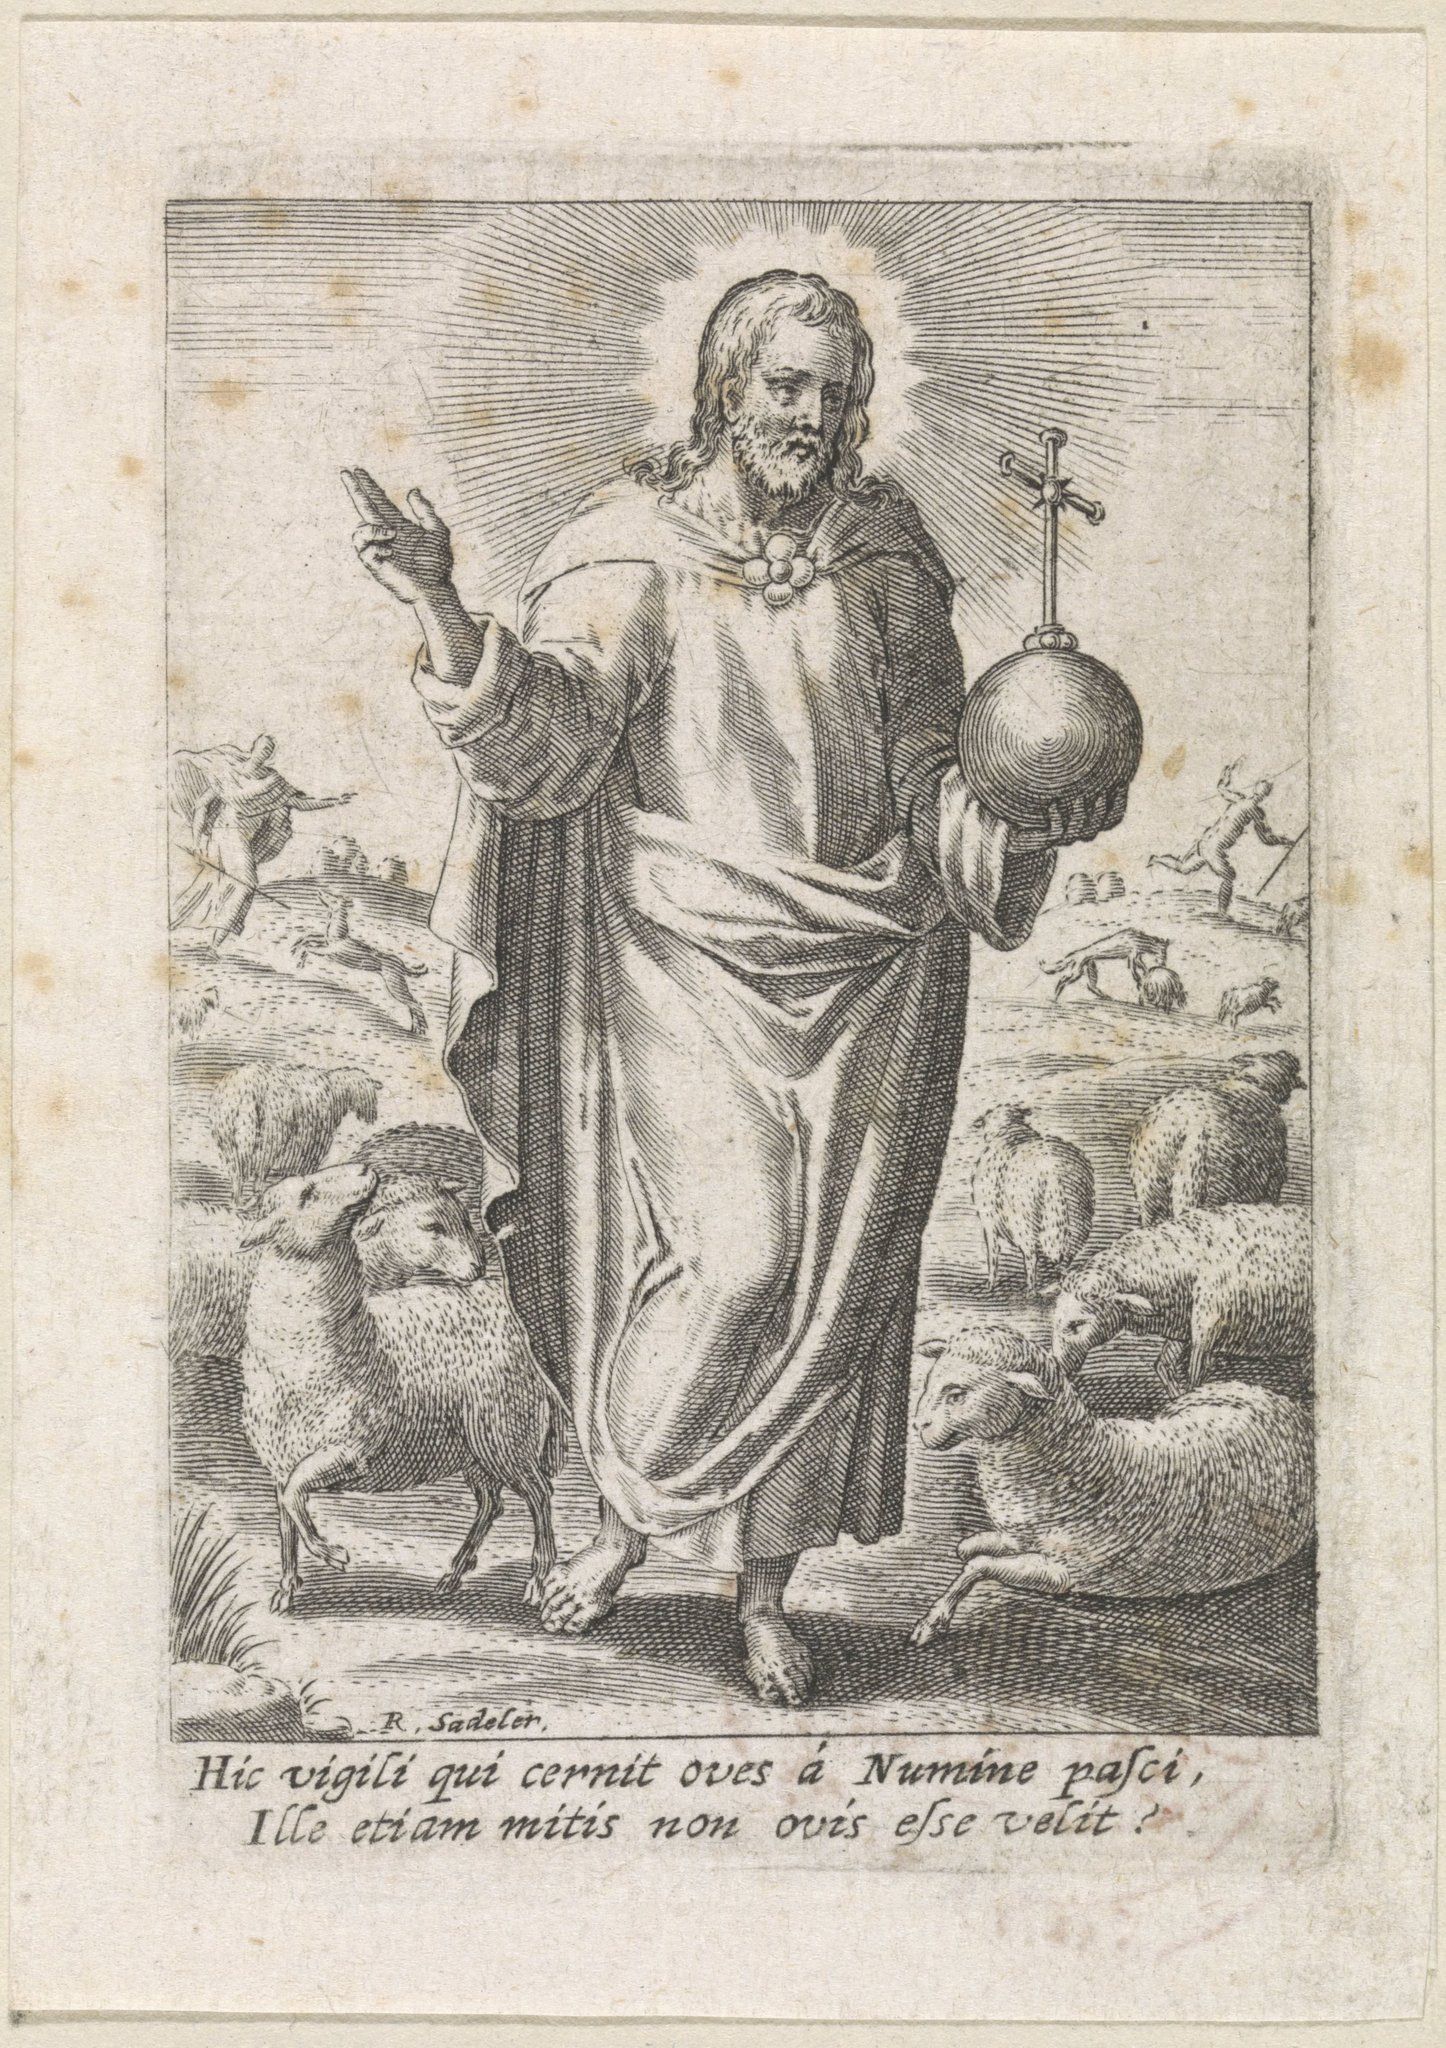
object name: book illustration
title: Christus als Goede Herder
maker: anna bergia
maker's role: publisher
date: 1617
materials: paper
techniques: engraving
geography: munich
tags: the good shepherd (christ) defending his sheep against wolves; 'i am the good shepherd' (john 10:1-16)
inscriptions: collector's mark: Lugt 240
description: Christus staat tussen de schapen. In zijn handen een rijksappel. Op de achtergrond verjaagt Christus een wolf die zijn schapen bedreigt.